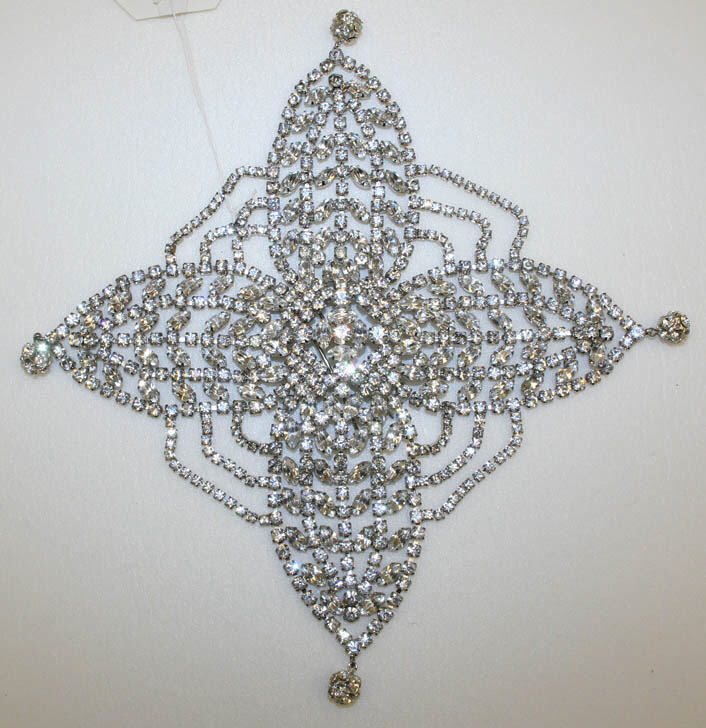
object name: hair accessory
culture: american or european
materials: glass, metal